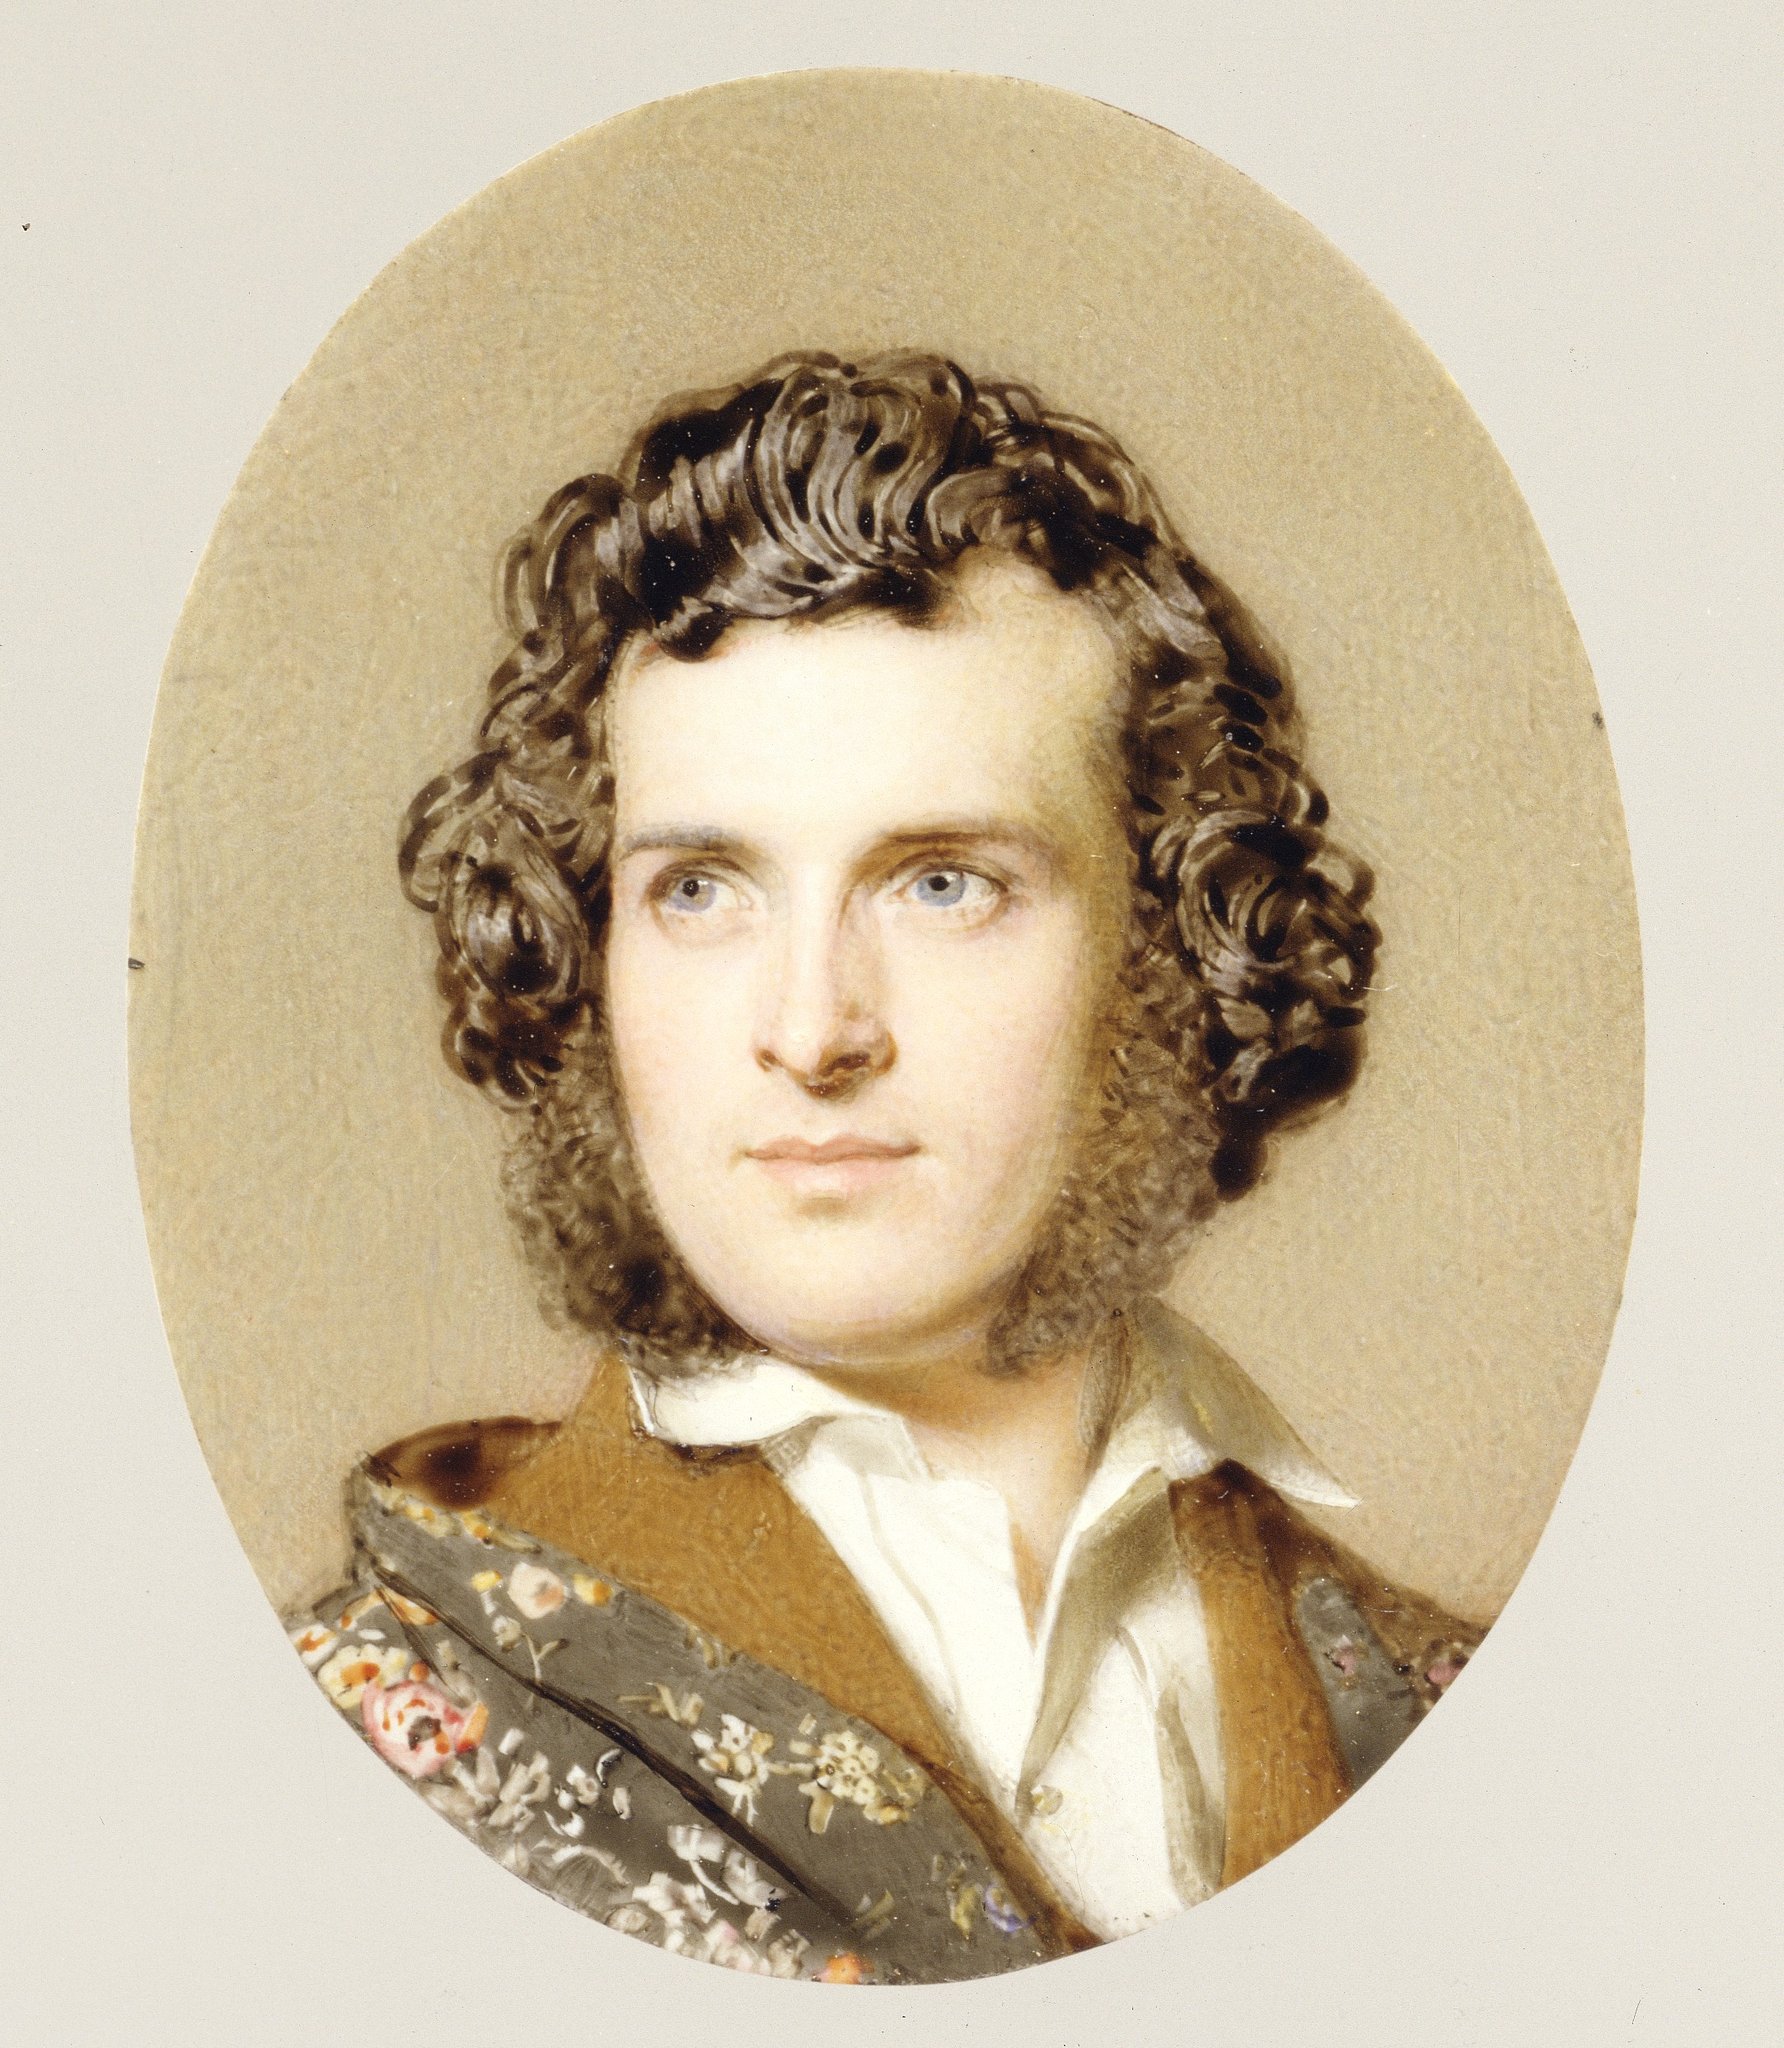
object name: painting, miniature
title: Self-Portrait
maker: john faed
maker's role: artist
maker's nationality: british, scottish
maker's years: 1820-1902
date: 1850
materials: ivory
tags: men,self-portraits